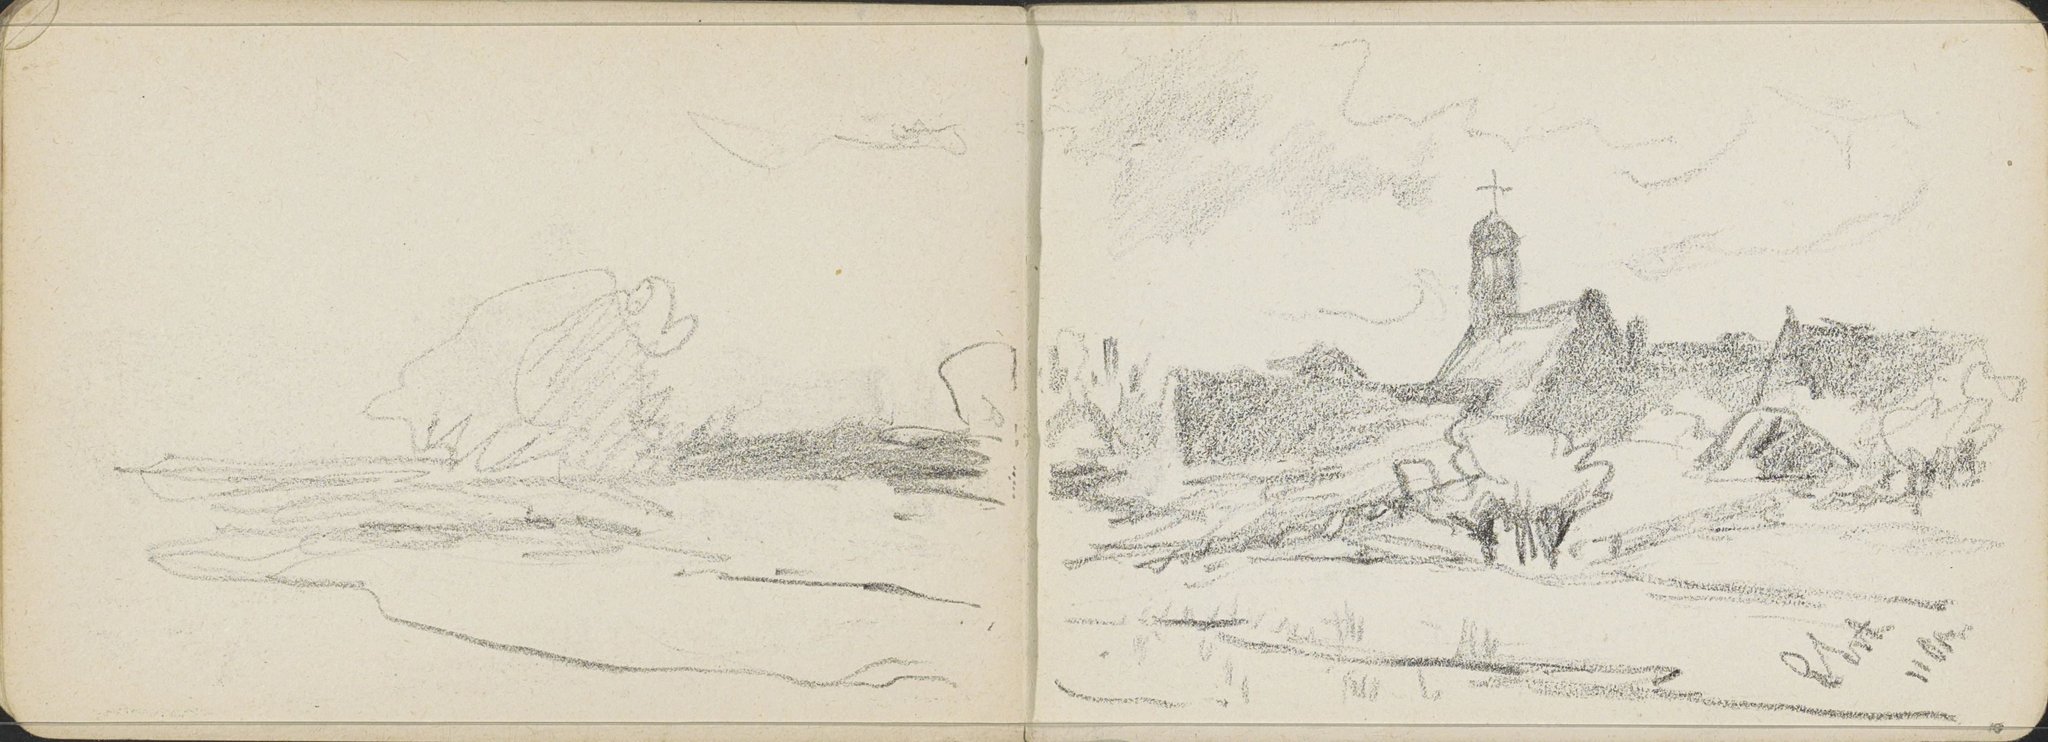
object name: sketchbook leaf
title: Gezicht op Elst met de toren van de Werenfridus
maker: willem cornelis rip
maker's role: draughtsman, painter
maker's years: 1856-1922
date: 1905-1910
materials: chalk, paper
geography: elst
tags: village, parts of church exterior and annexes: tower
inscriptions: date and inscription: ‘Elst/ 11 Oct’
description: Blad 9 verso en 10 recto uit een schetsboek met 42 bladen.